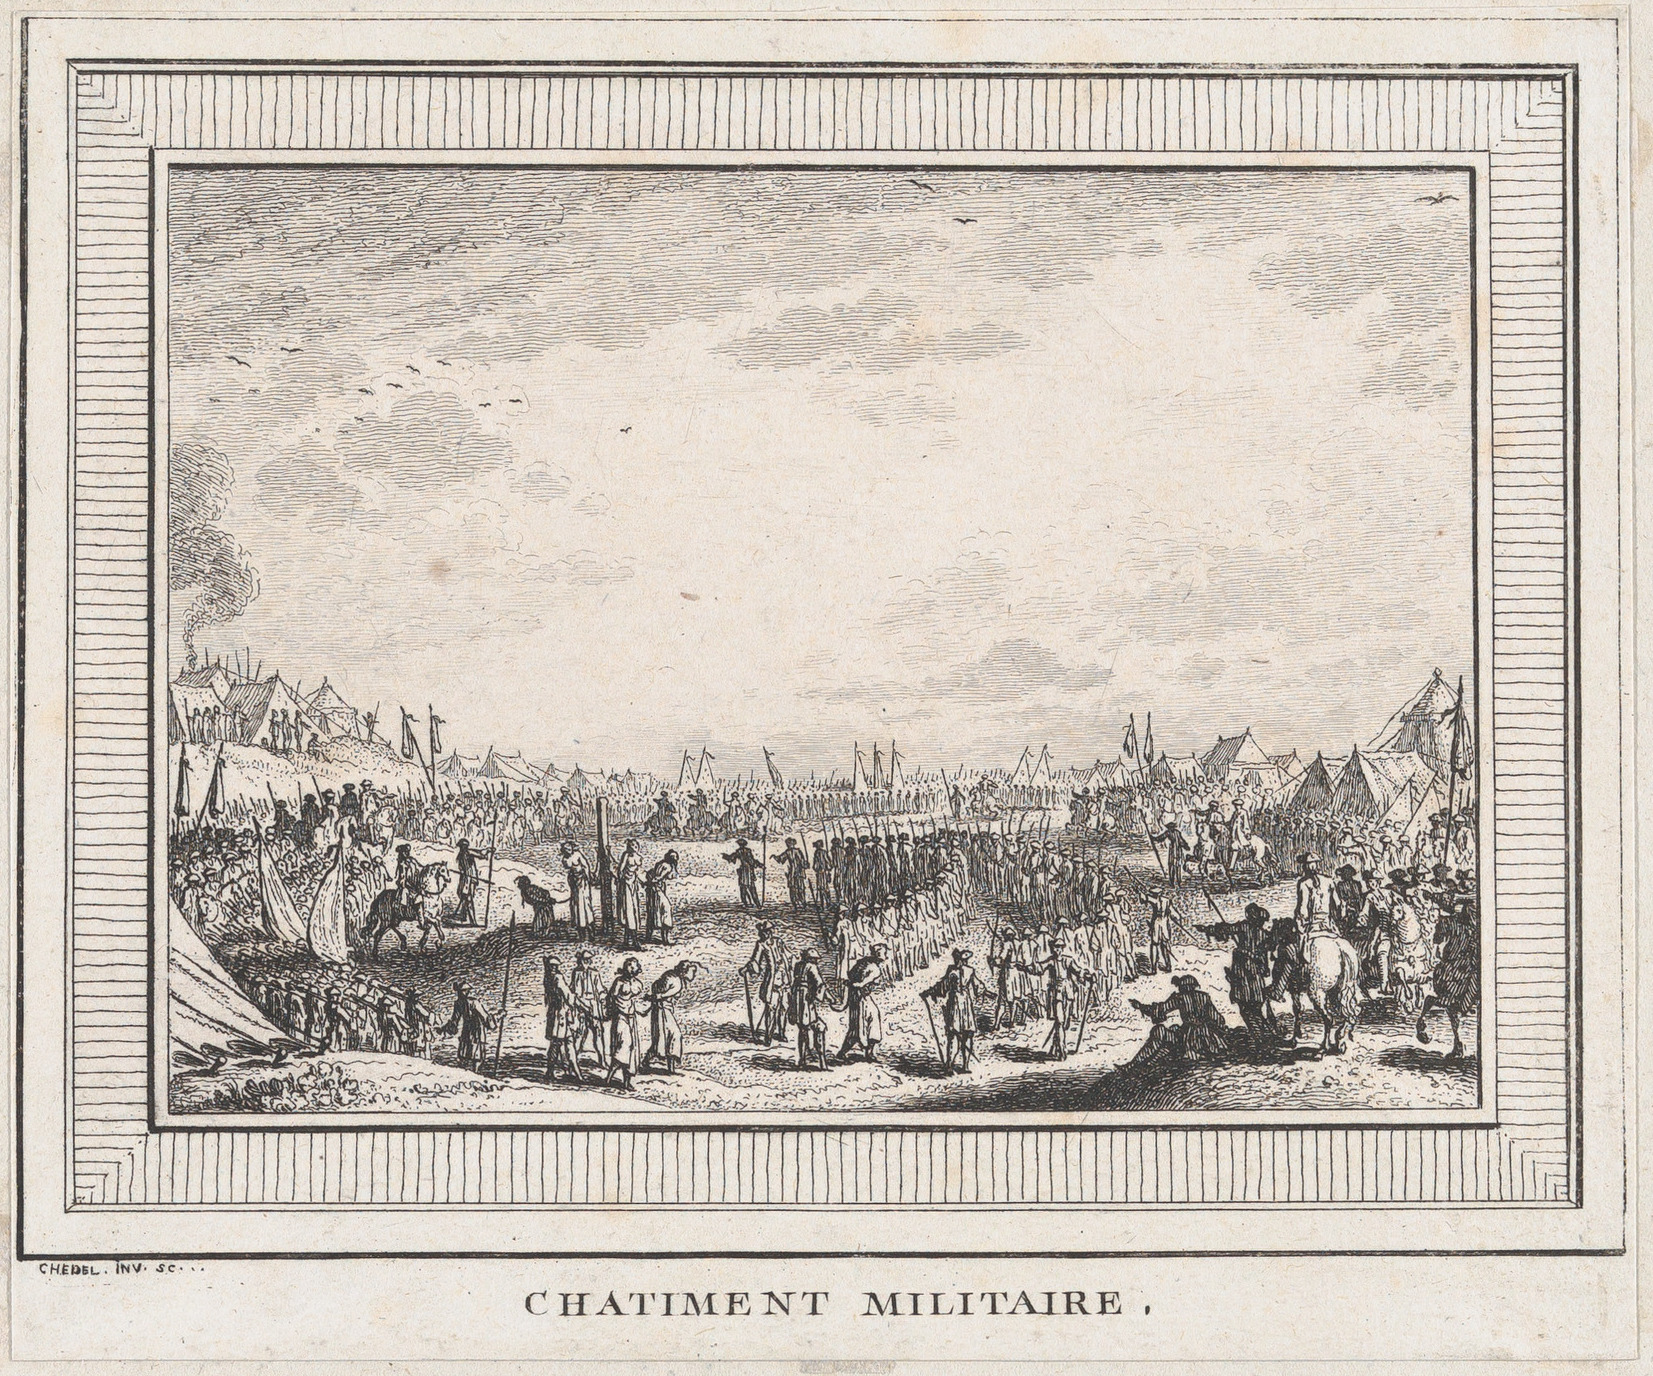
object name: print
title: Chatiment Militaire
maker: quentin pierre chedel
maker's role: artist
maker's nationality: french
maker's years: 1705-1763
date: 1701-1800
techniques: etching